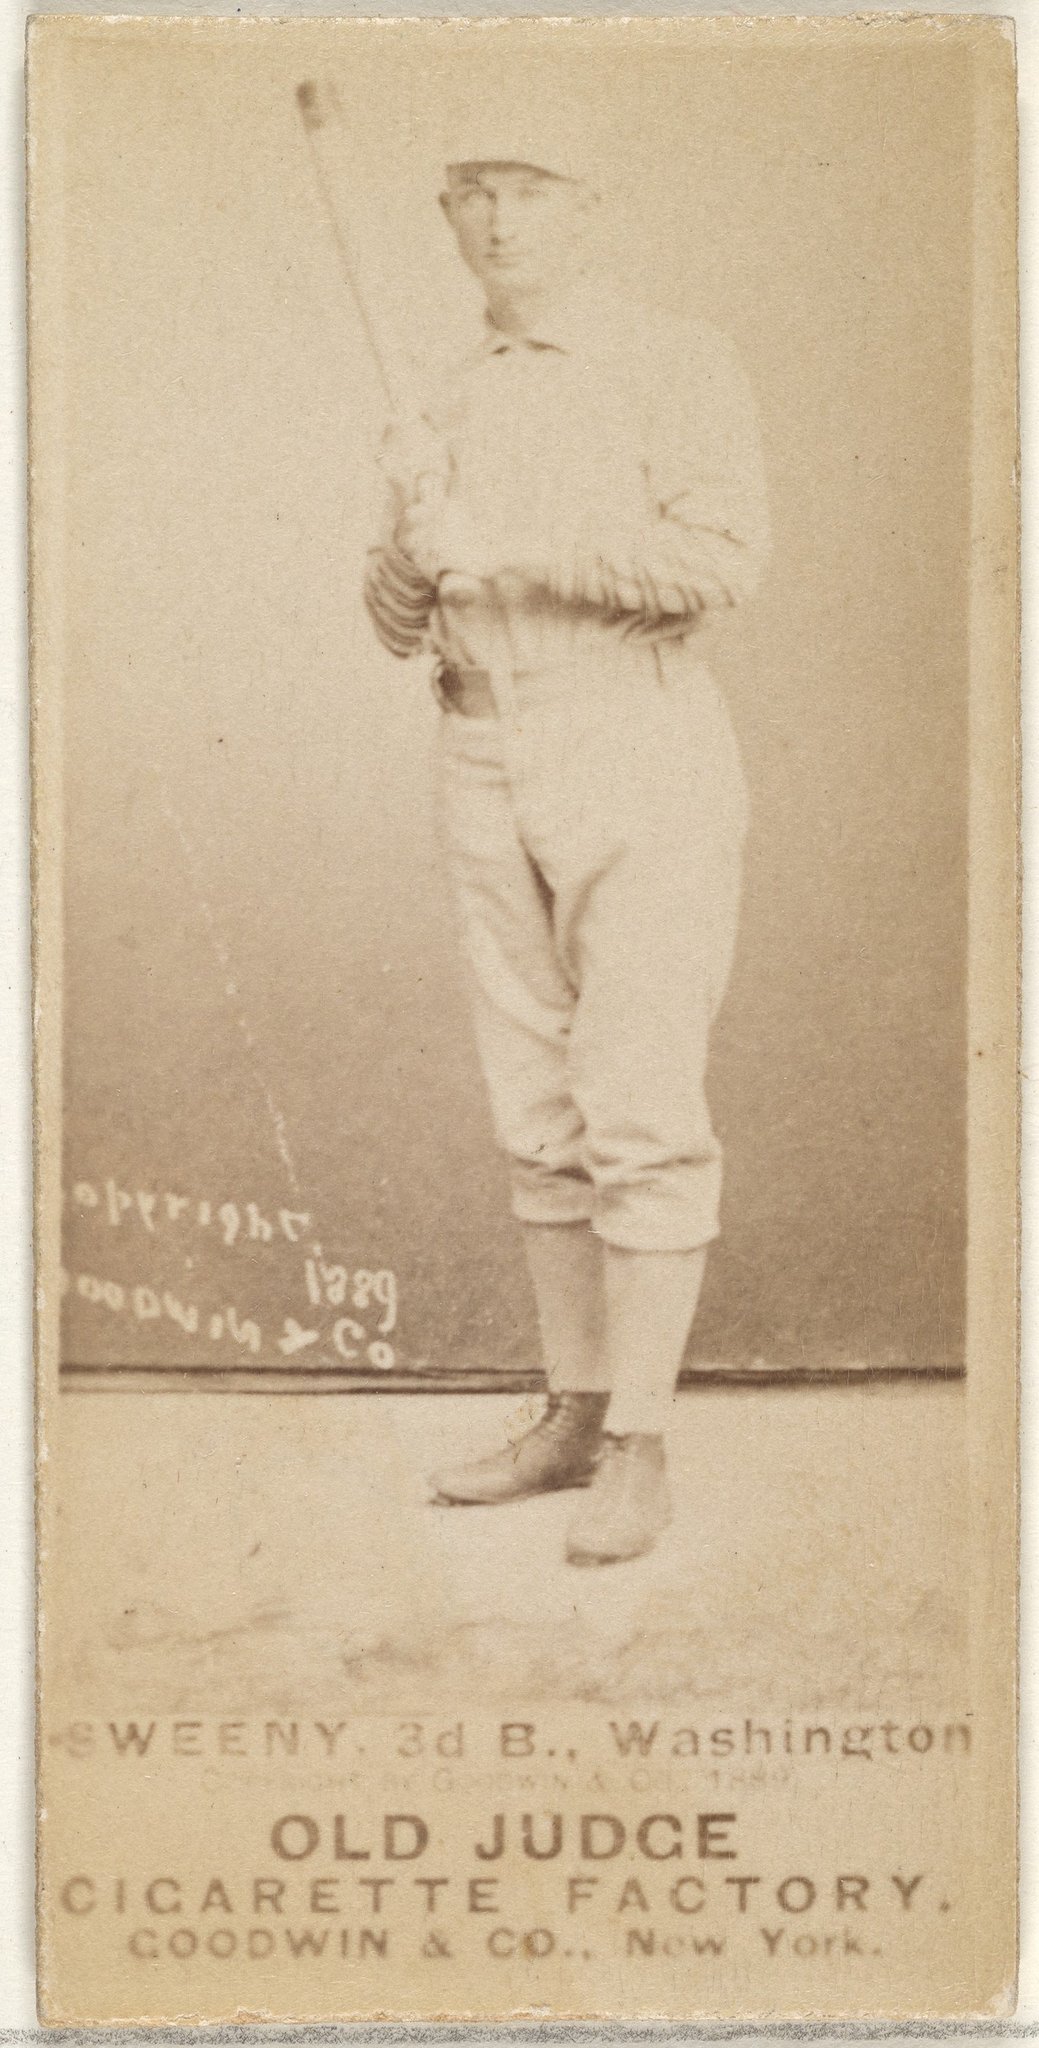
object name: baseball card, photograph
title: Peter Jay "Pete" Sweeny, 3rd Base, Washington Nationals, from the Old Judge series (N172) for Old Judge Cigarettes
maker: goodwin & company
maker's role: publisher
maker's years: 1850-1950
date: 1889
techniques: albumen silver print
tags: men,portraits,baseball,athletes